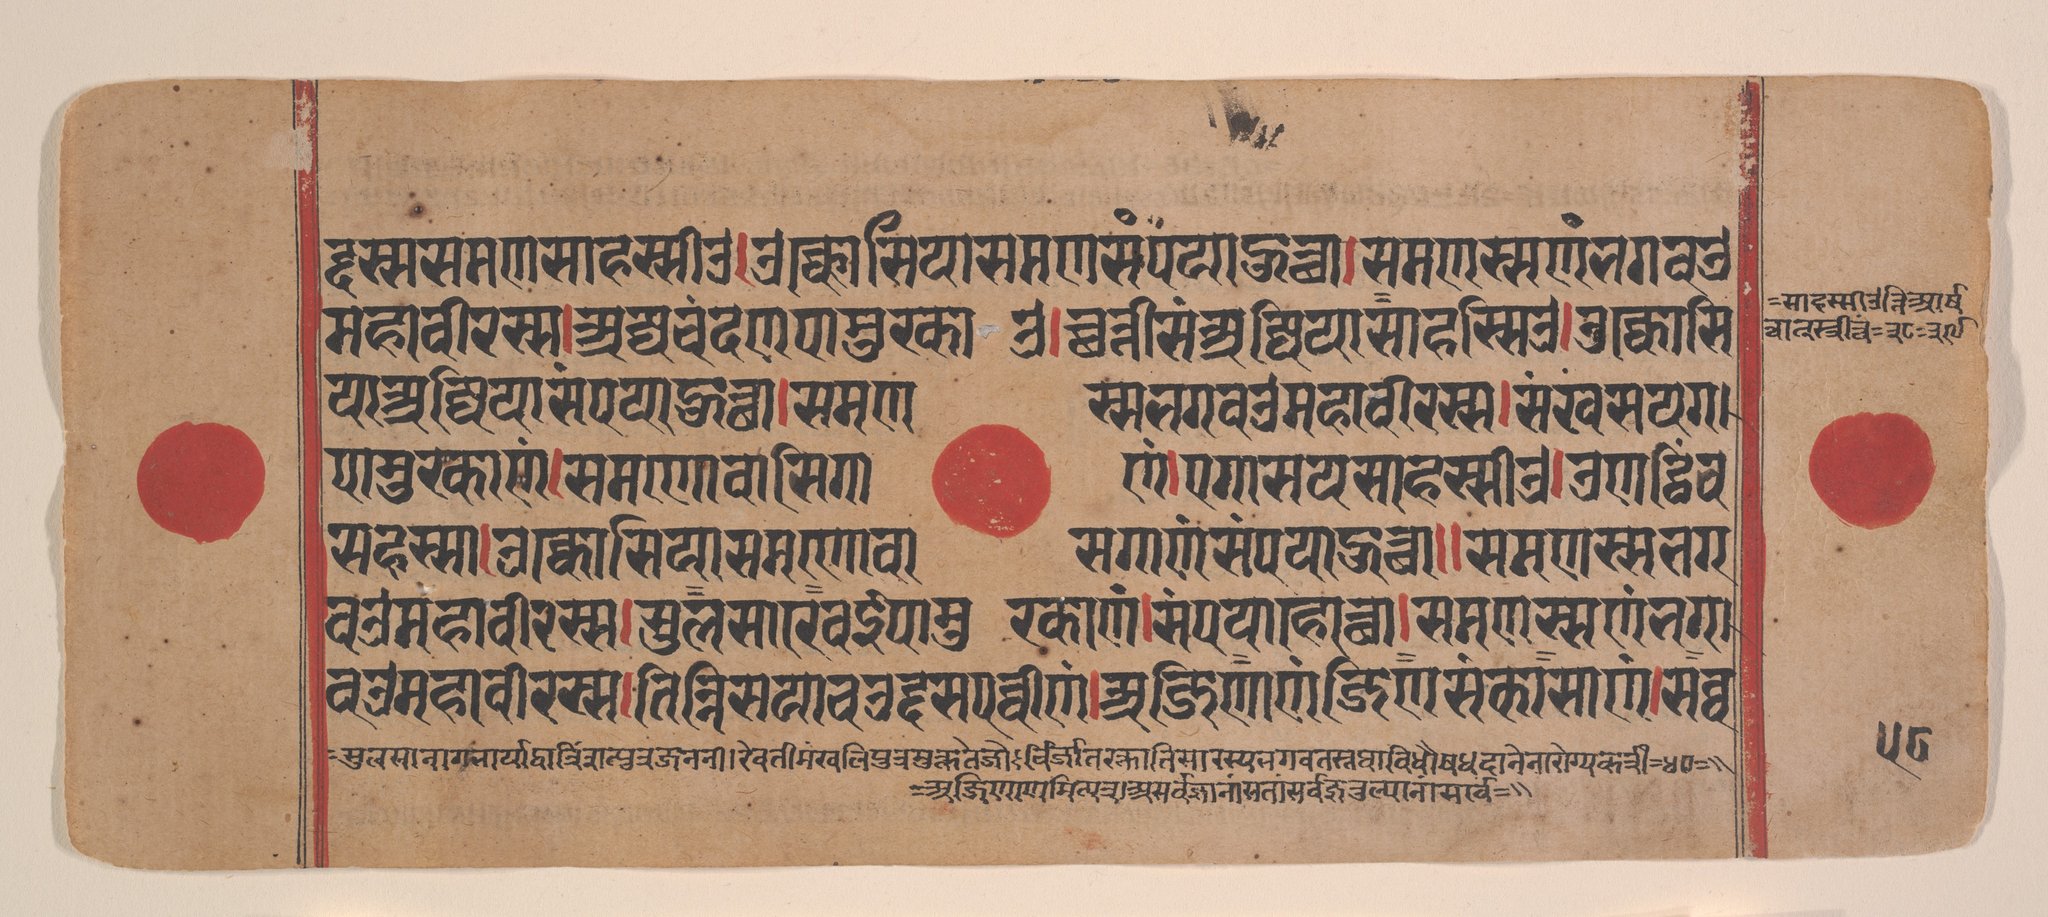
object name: folio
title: Page from a Dispersed Kalpa Sutra (Jain Book of Rituals)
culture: indian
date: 1401-1500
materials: gold, ink, paper, watercolor